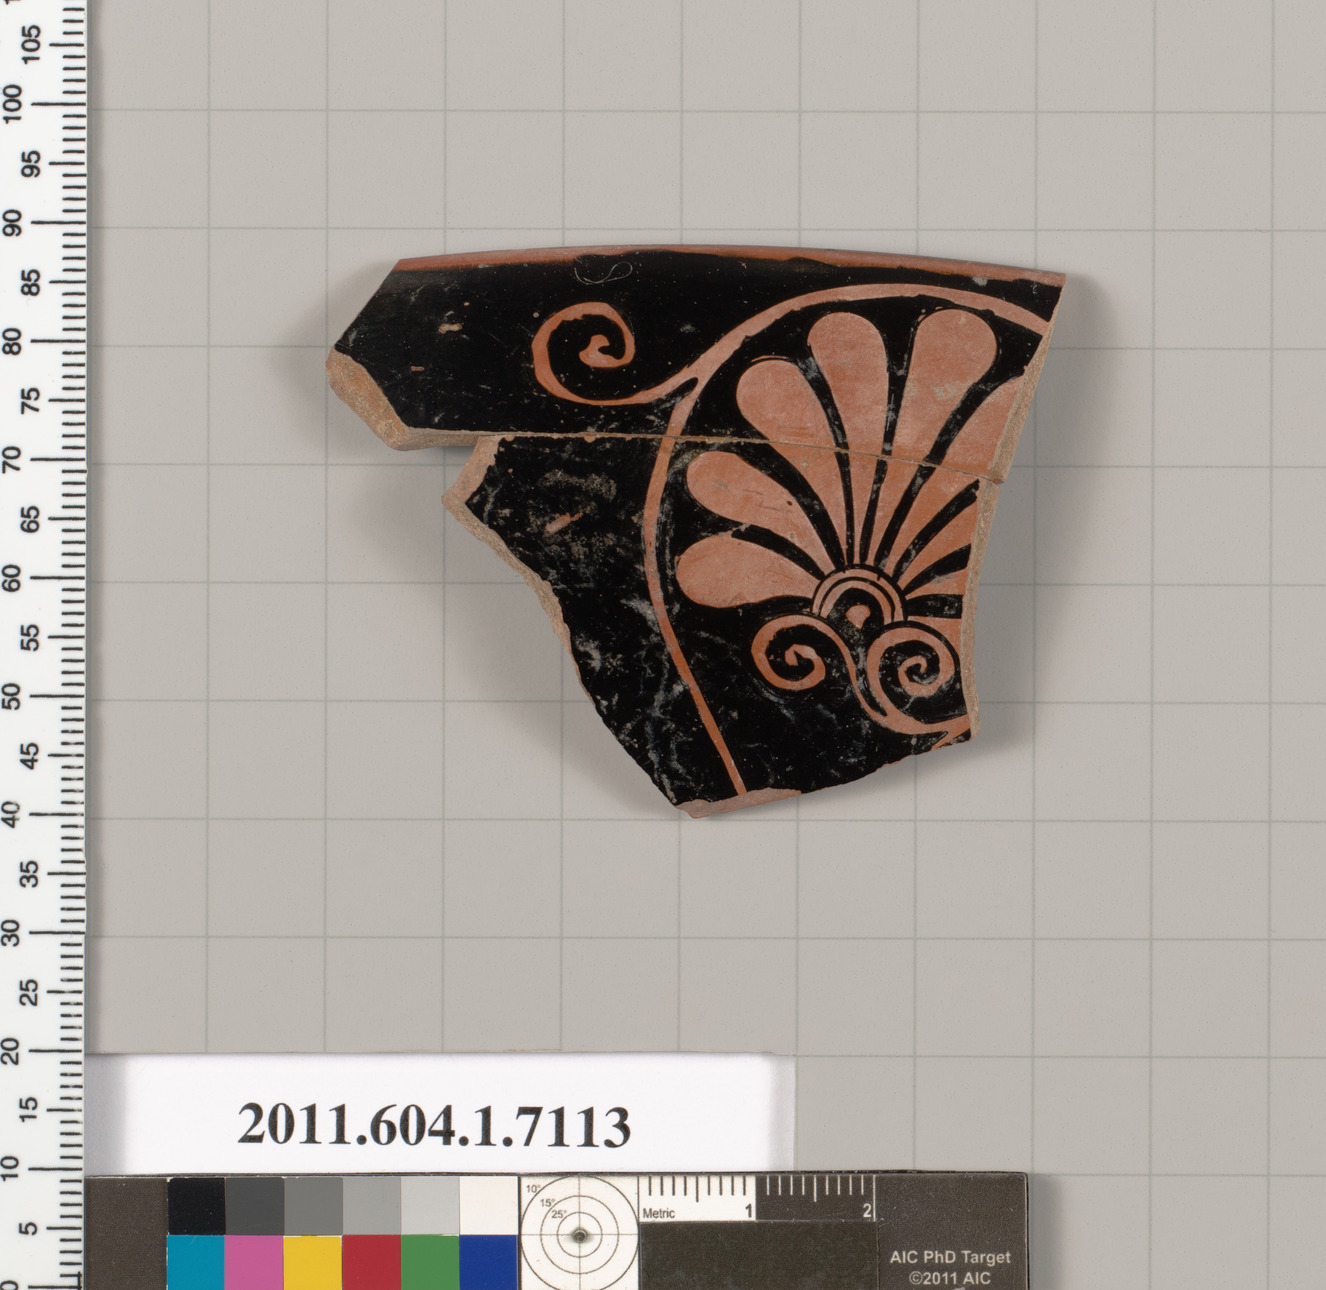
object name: kylix fragment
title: Terracotta rim fragment of a kylix (drinking cup)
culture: greek, attic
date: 500-480 BCE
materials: terracotta